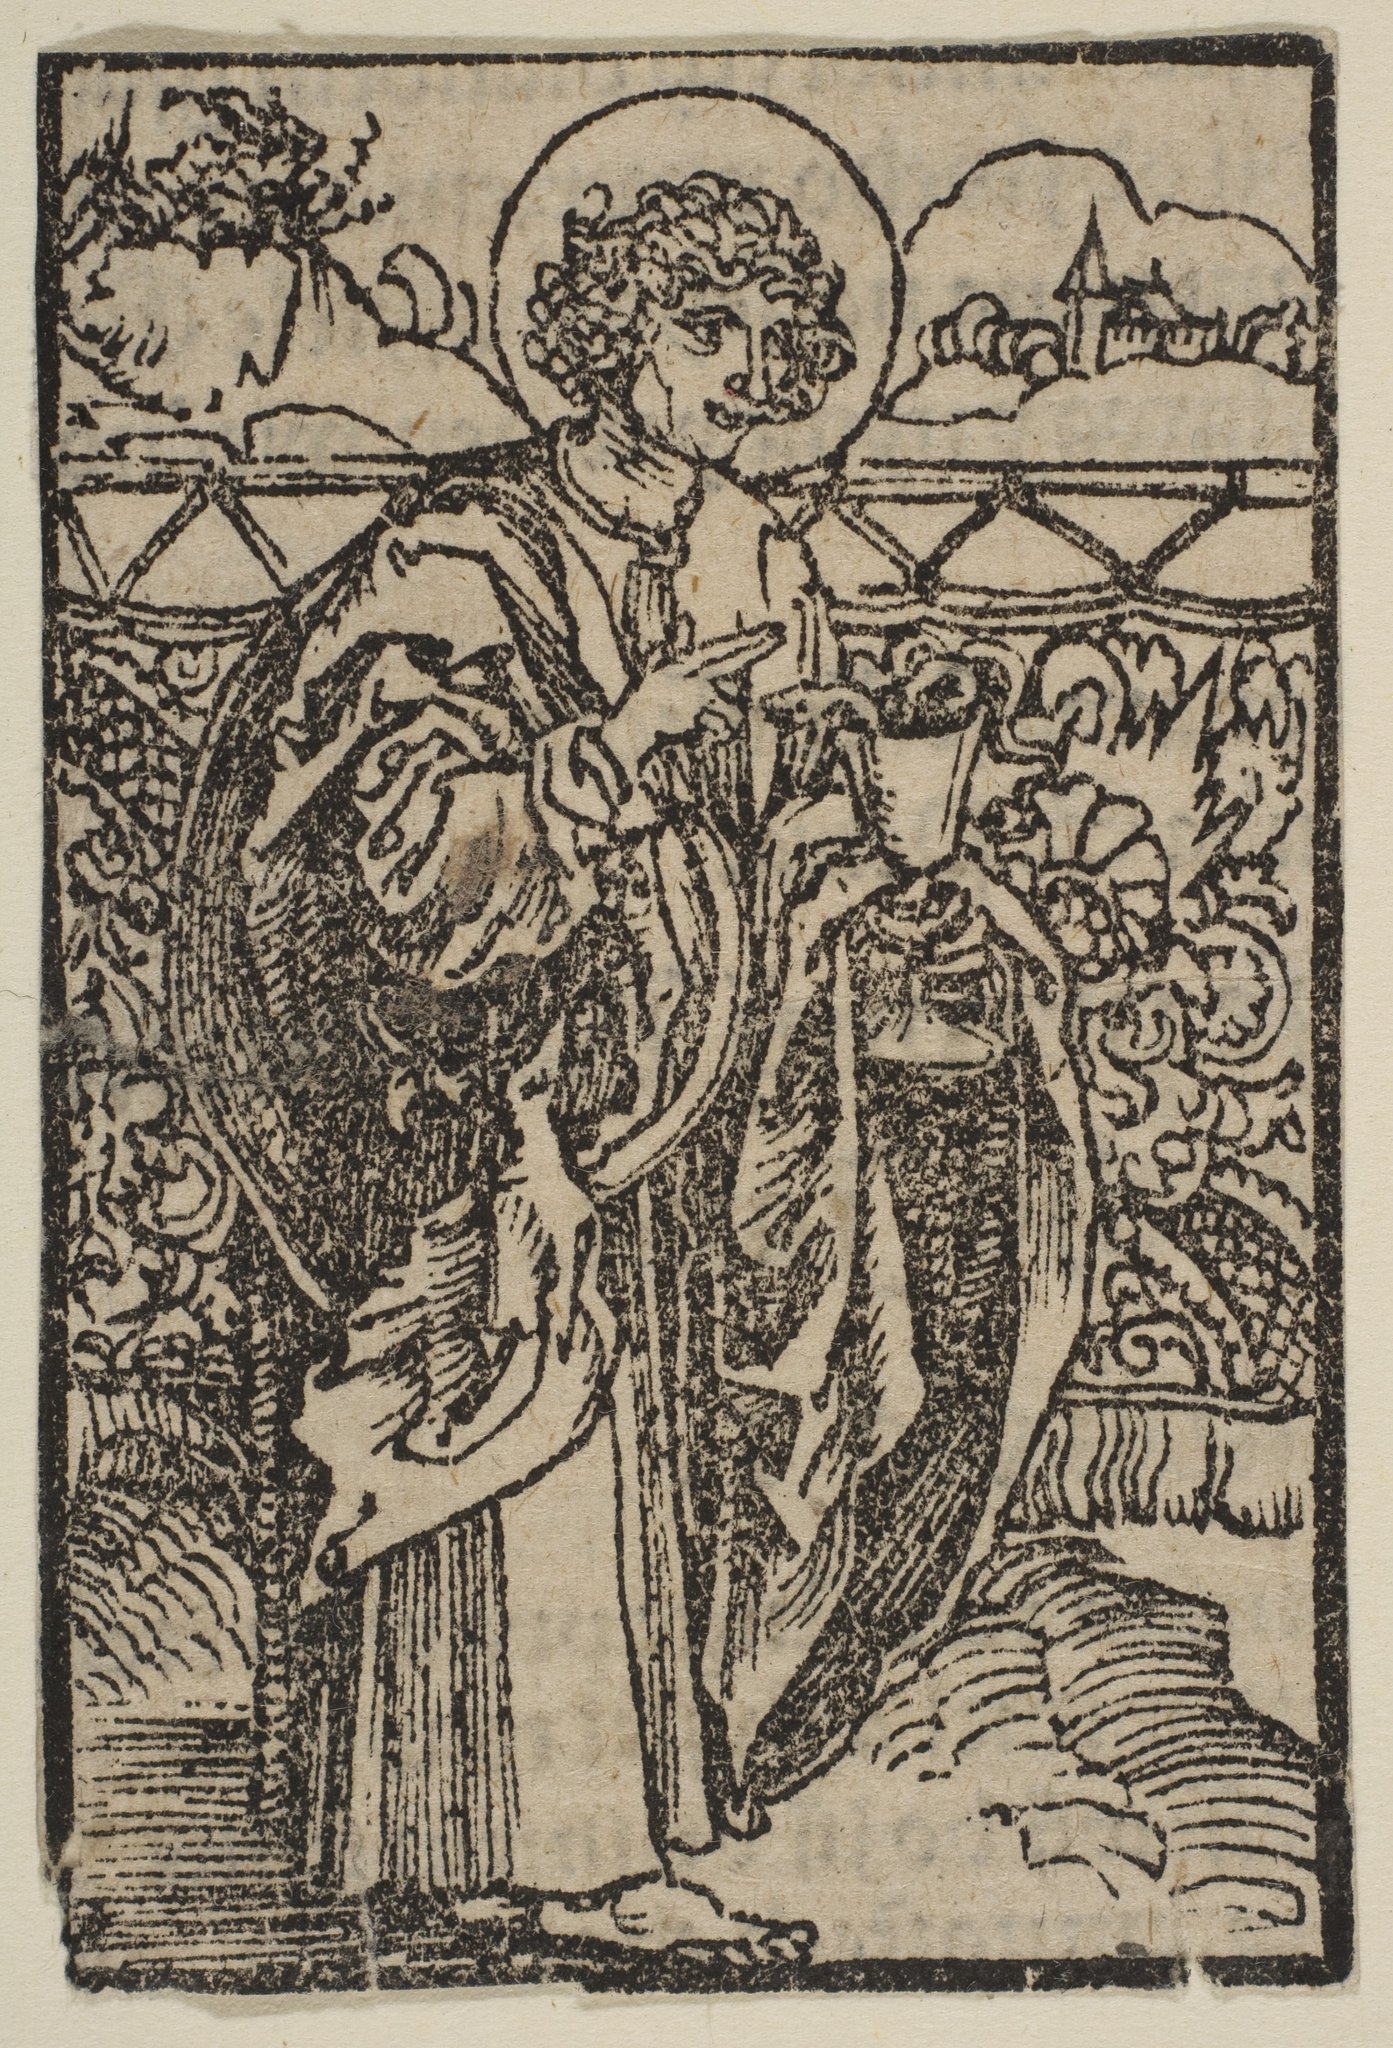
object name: print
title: Saint John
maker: albrecht dürer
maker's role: artist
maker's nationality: german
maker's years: 1471-1528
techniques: woodcut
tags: men,saint john the evangelist